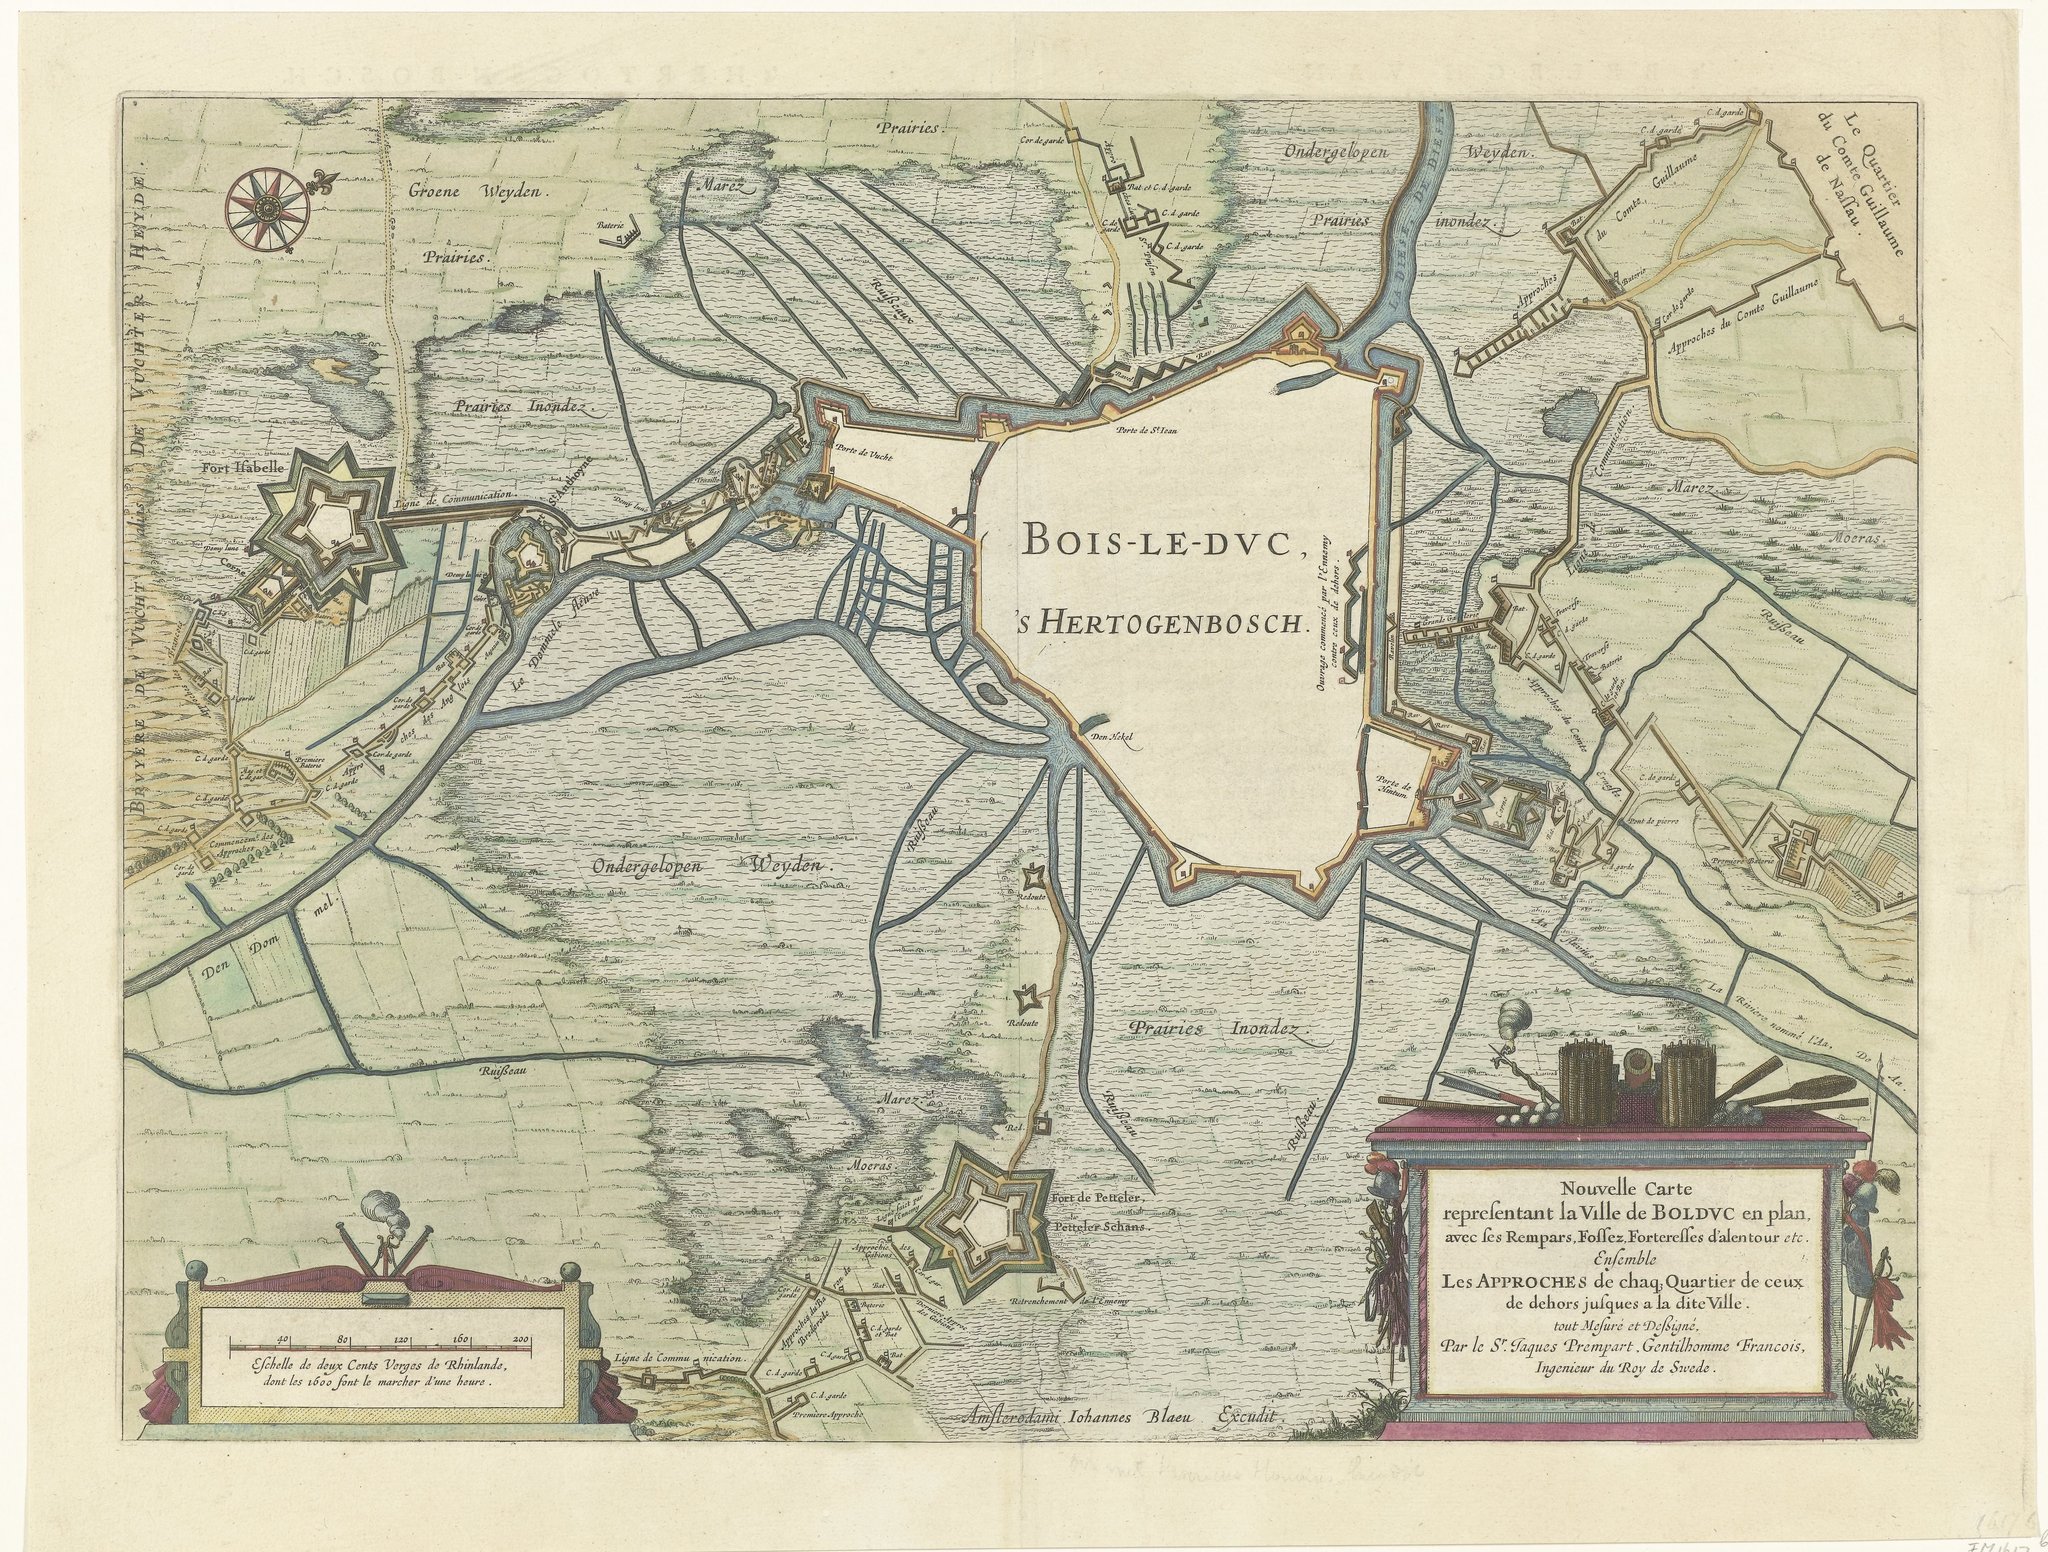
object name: history print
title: Kaart van het beleg van Den Bosch door Frederik Hendrik, 1629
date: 1652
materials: paper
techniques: etching, hand coloring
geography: northern netherlands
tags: the hague, frederick henry (prince of orange), maps of separate countries or regions, siege, position war, den bosch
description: Kaart van het beleg van Den Bosch door het Staatse leger onder Frederik Hendrik, van 1 mei tot 17 september 1629. Kaart met centraal de versterkte stad, links fort Isabella. Rechtsonder een cartouche met de Franse titel. Dubbelblad genomen uit het Stedenboek van Blaeu, bedrukt op achterzijde met tekst in het Nederlands.